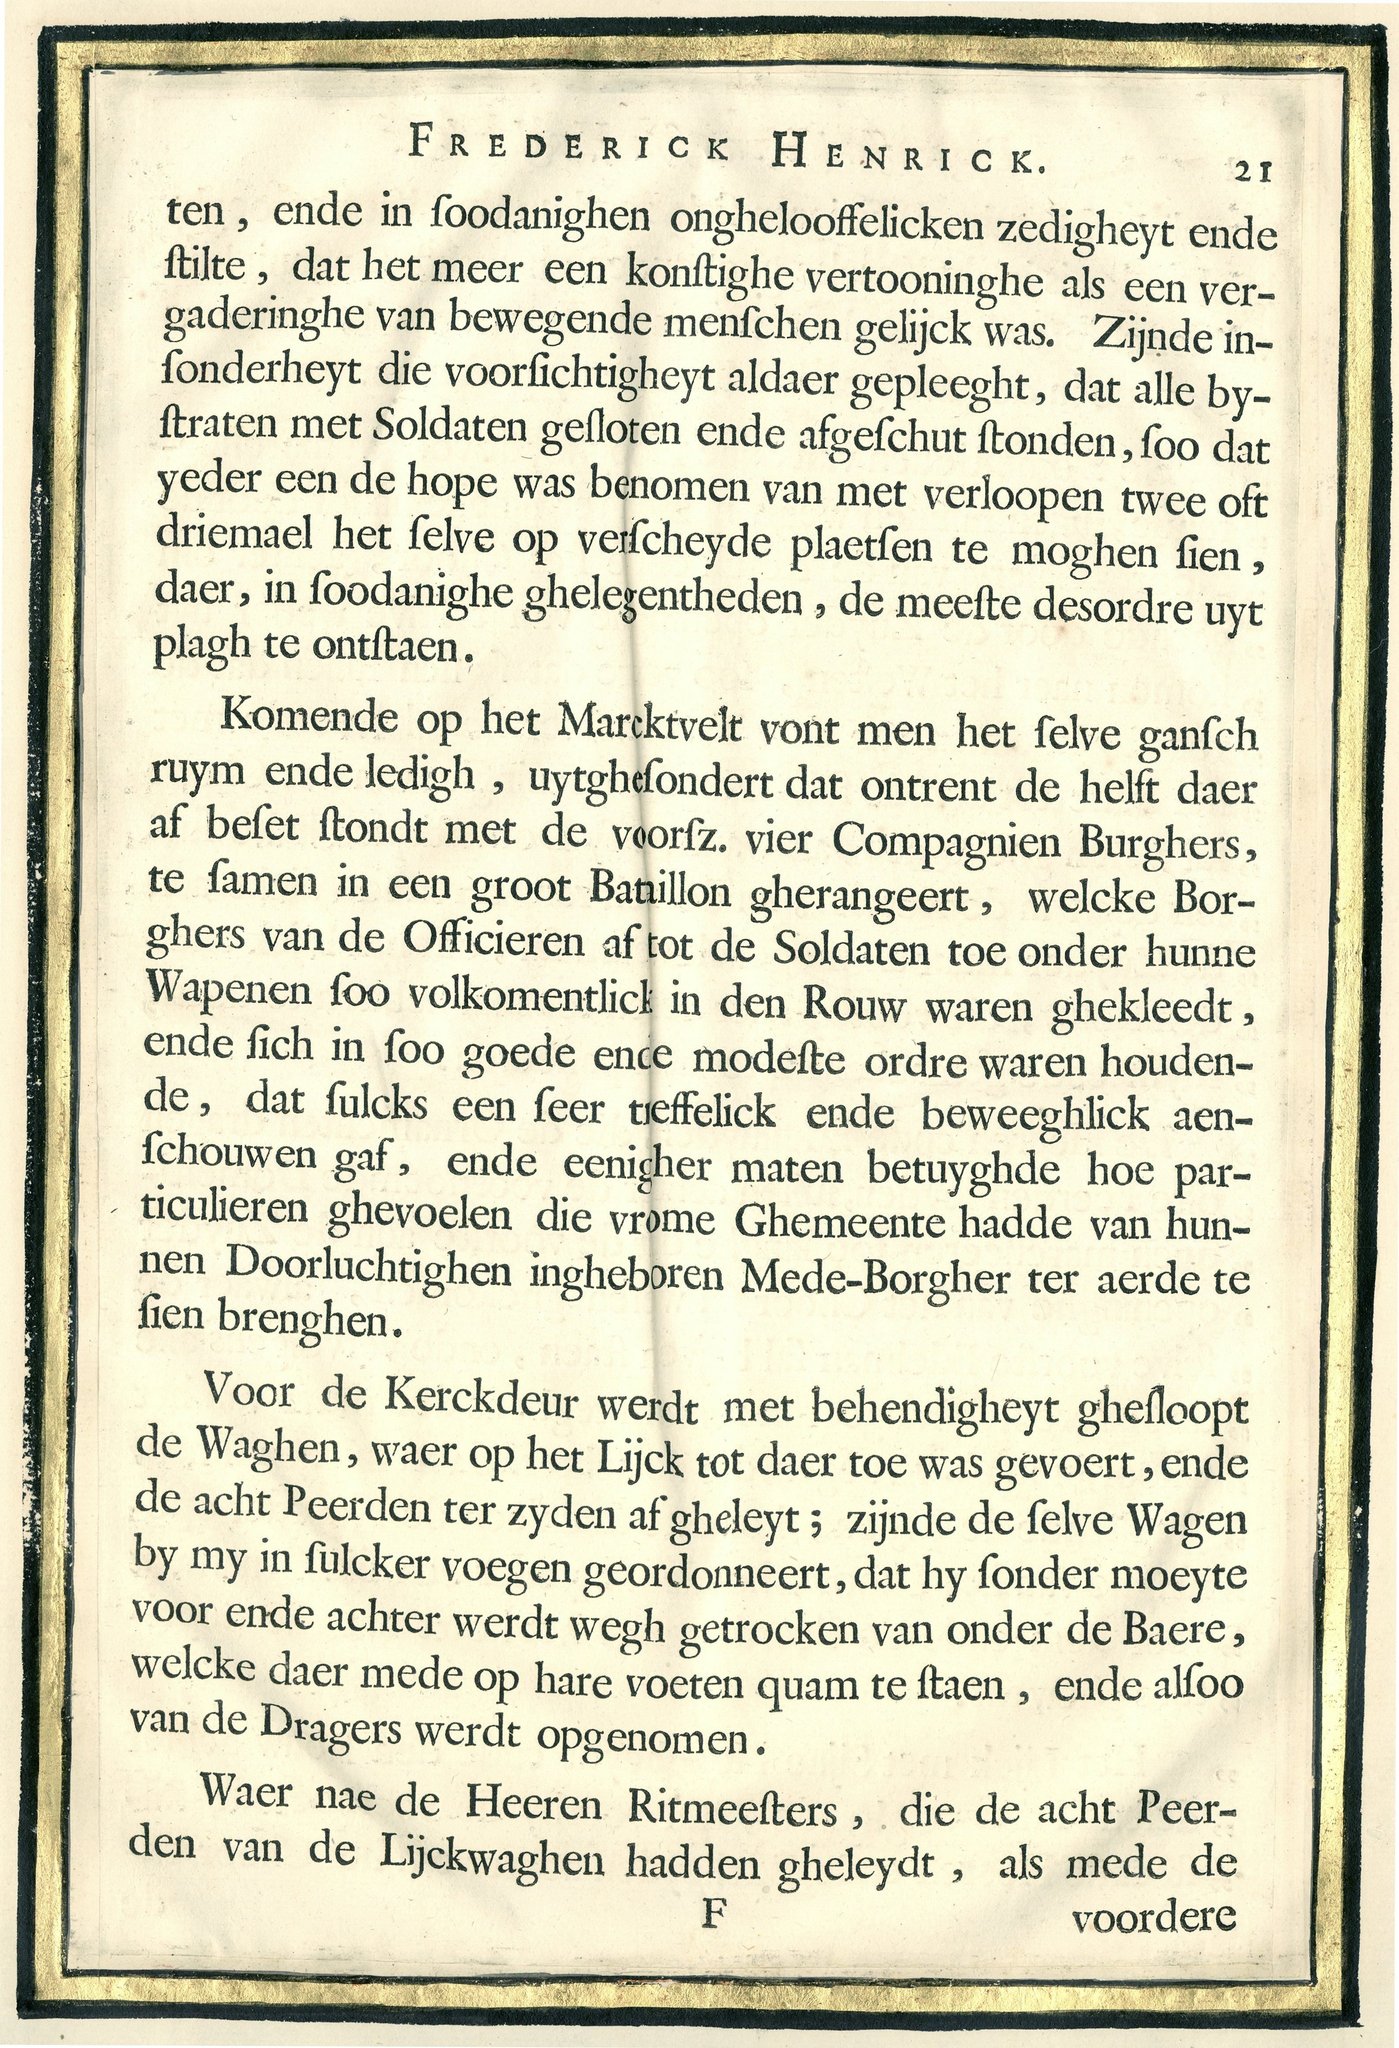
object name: book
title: Begraeffenisse van syne hoogheyt Frederick Henrick. Luxe ingekleurde uitgave van de prenten van de begrafenisstoet van Frederik Hendrik in 1647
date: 1651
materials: paint, paper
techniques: letterpress printing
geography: amsterdam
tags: the hague, frederick henry (prince of orange)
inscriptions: date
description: Pagina 21 van de beschrijving van de begrafenis van Frederik Hendrik. Blad uitgeknipt, versierd met goud en ingeplakt in de luxe editie uit ca. 1755 van het boek 'Begraeffenisse van syne hoogheyt Frederick Henrick' van Pieter Post, uitgegeven te Amsterdam in 1651.